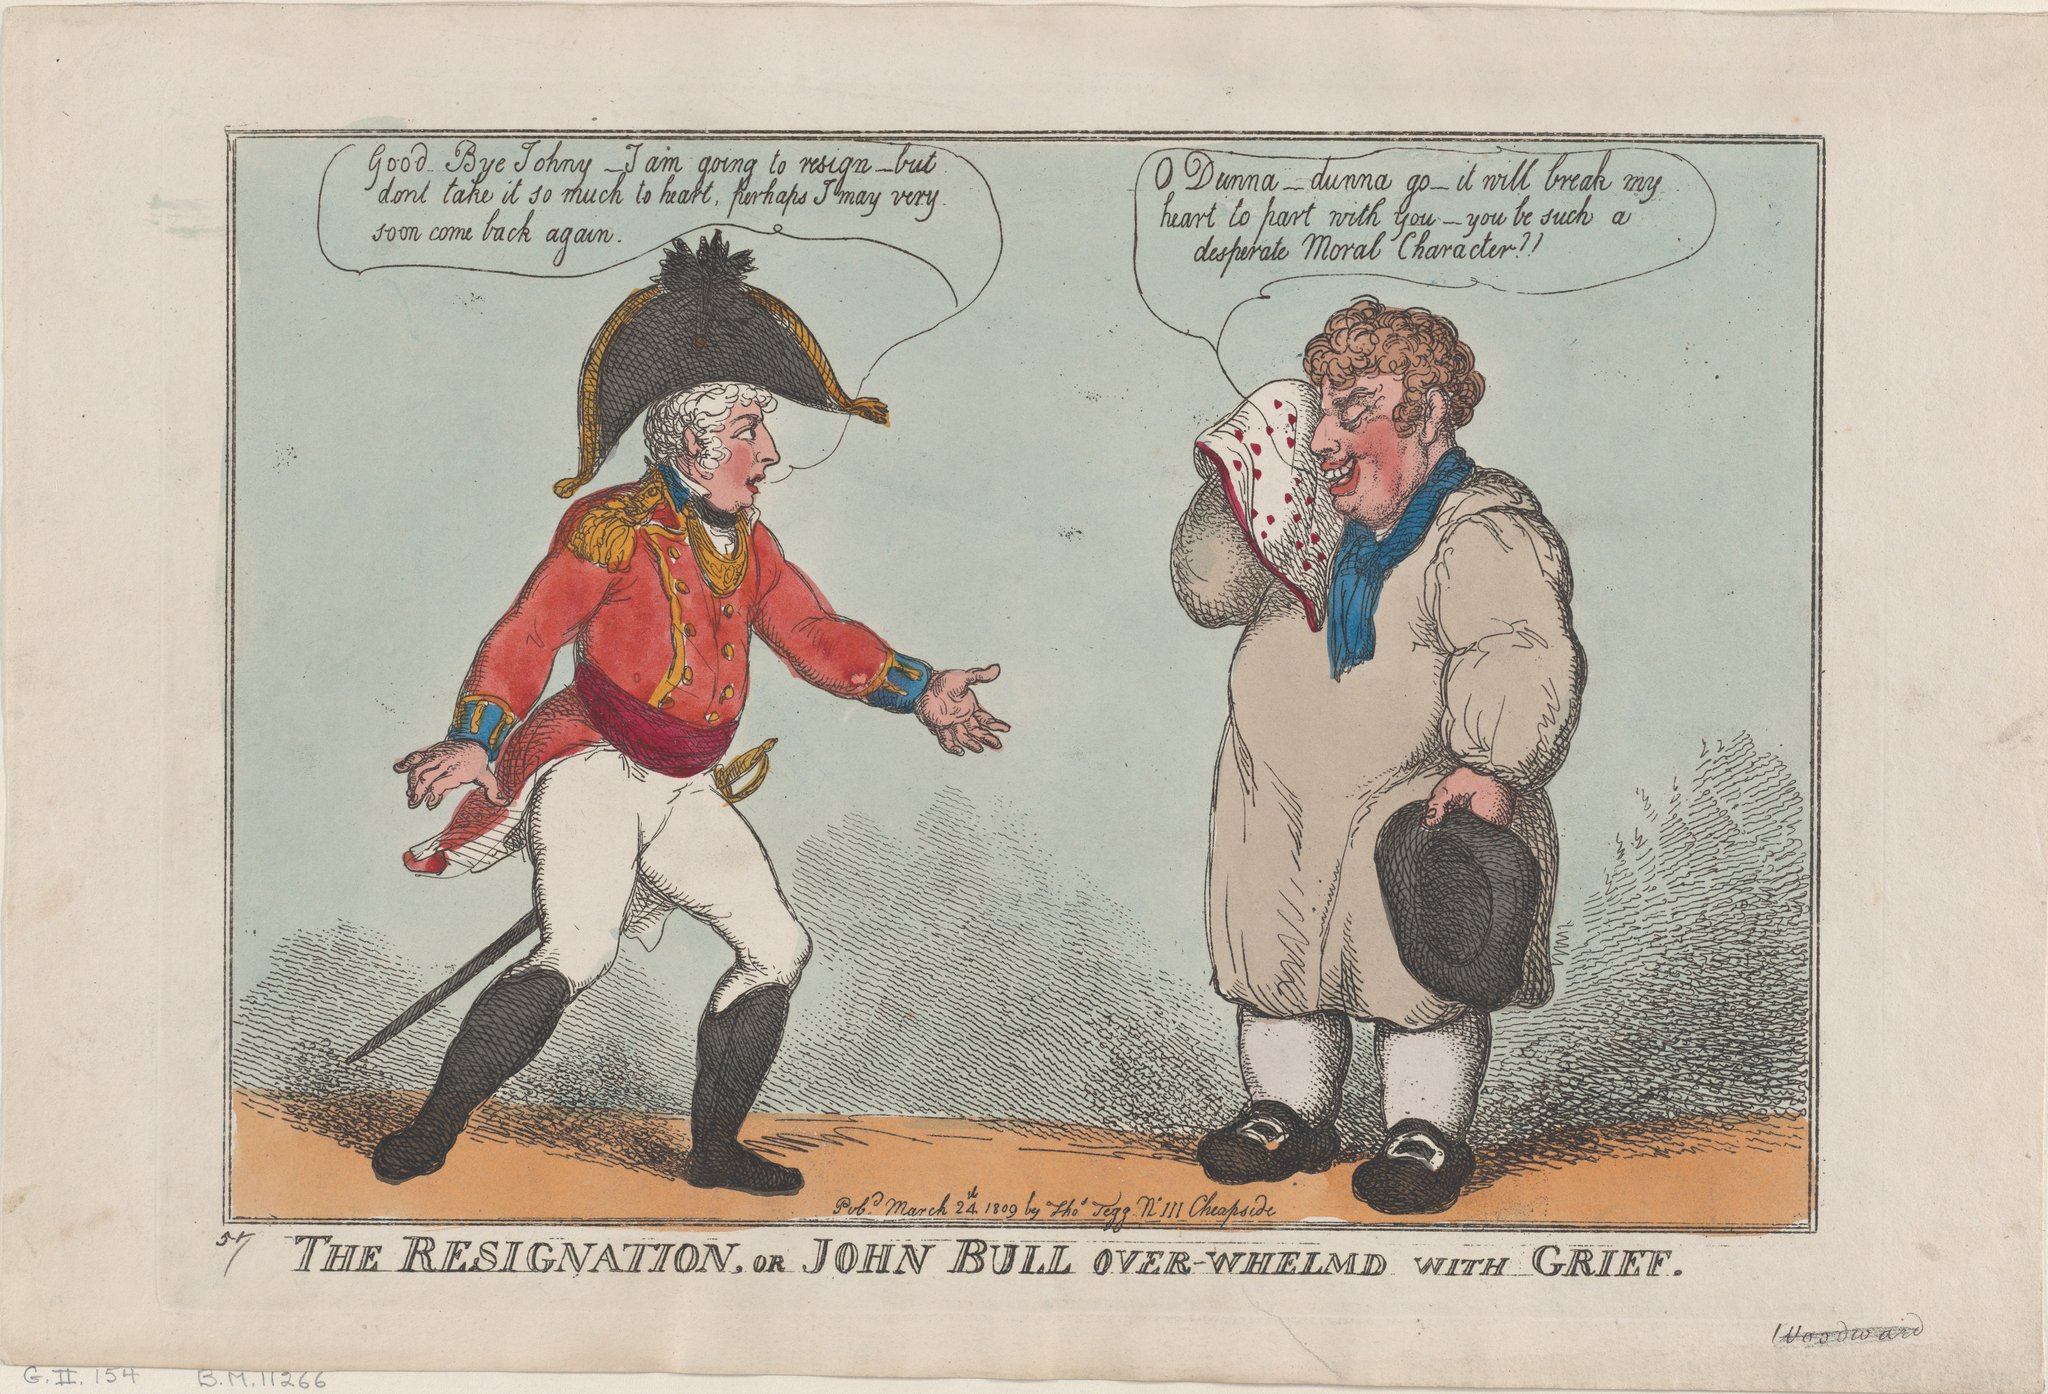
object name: print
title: The Resignation, or John Bull Over-Whelmed with Grief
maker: thomas rowlandson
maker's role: artist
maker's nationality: british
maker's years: 1757-1827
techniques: etching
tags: satire,men,politics